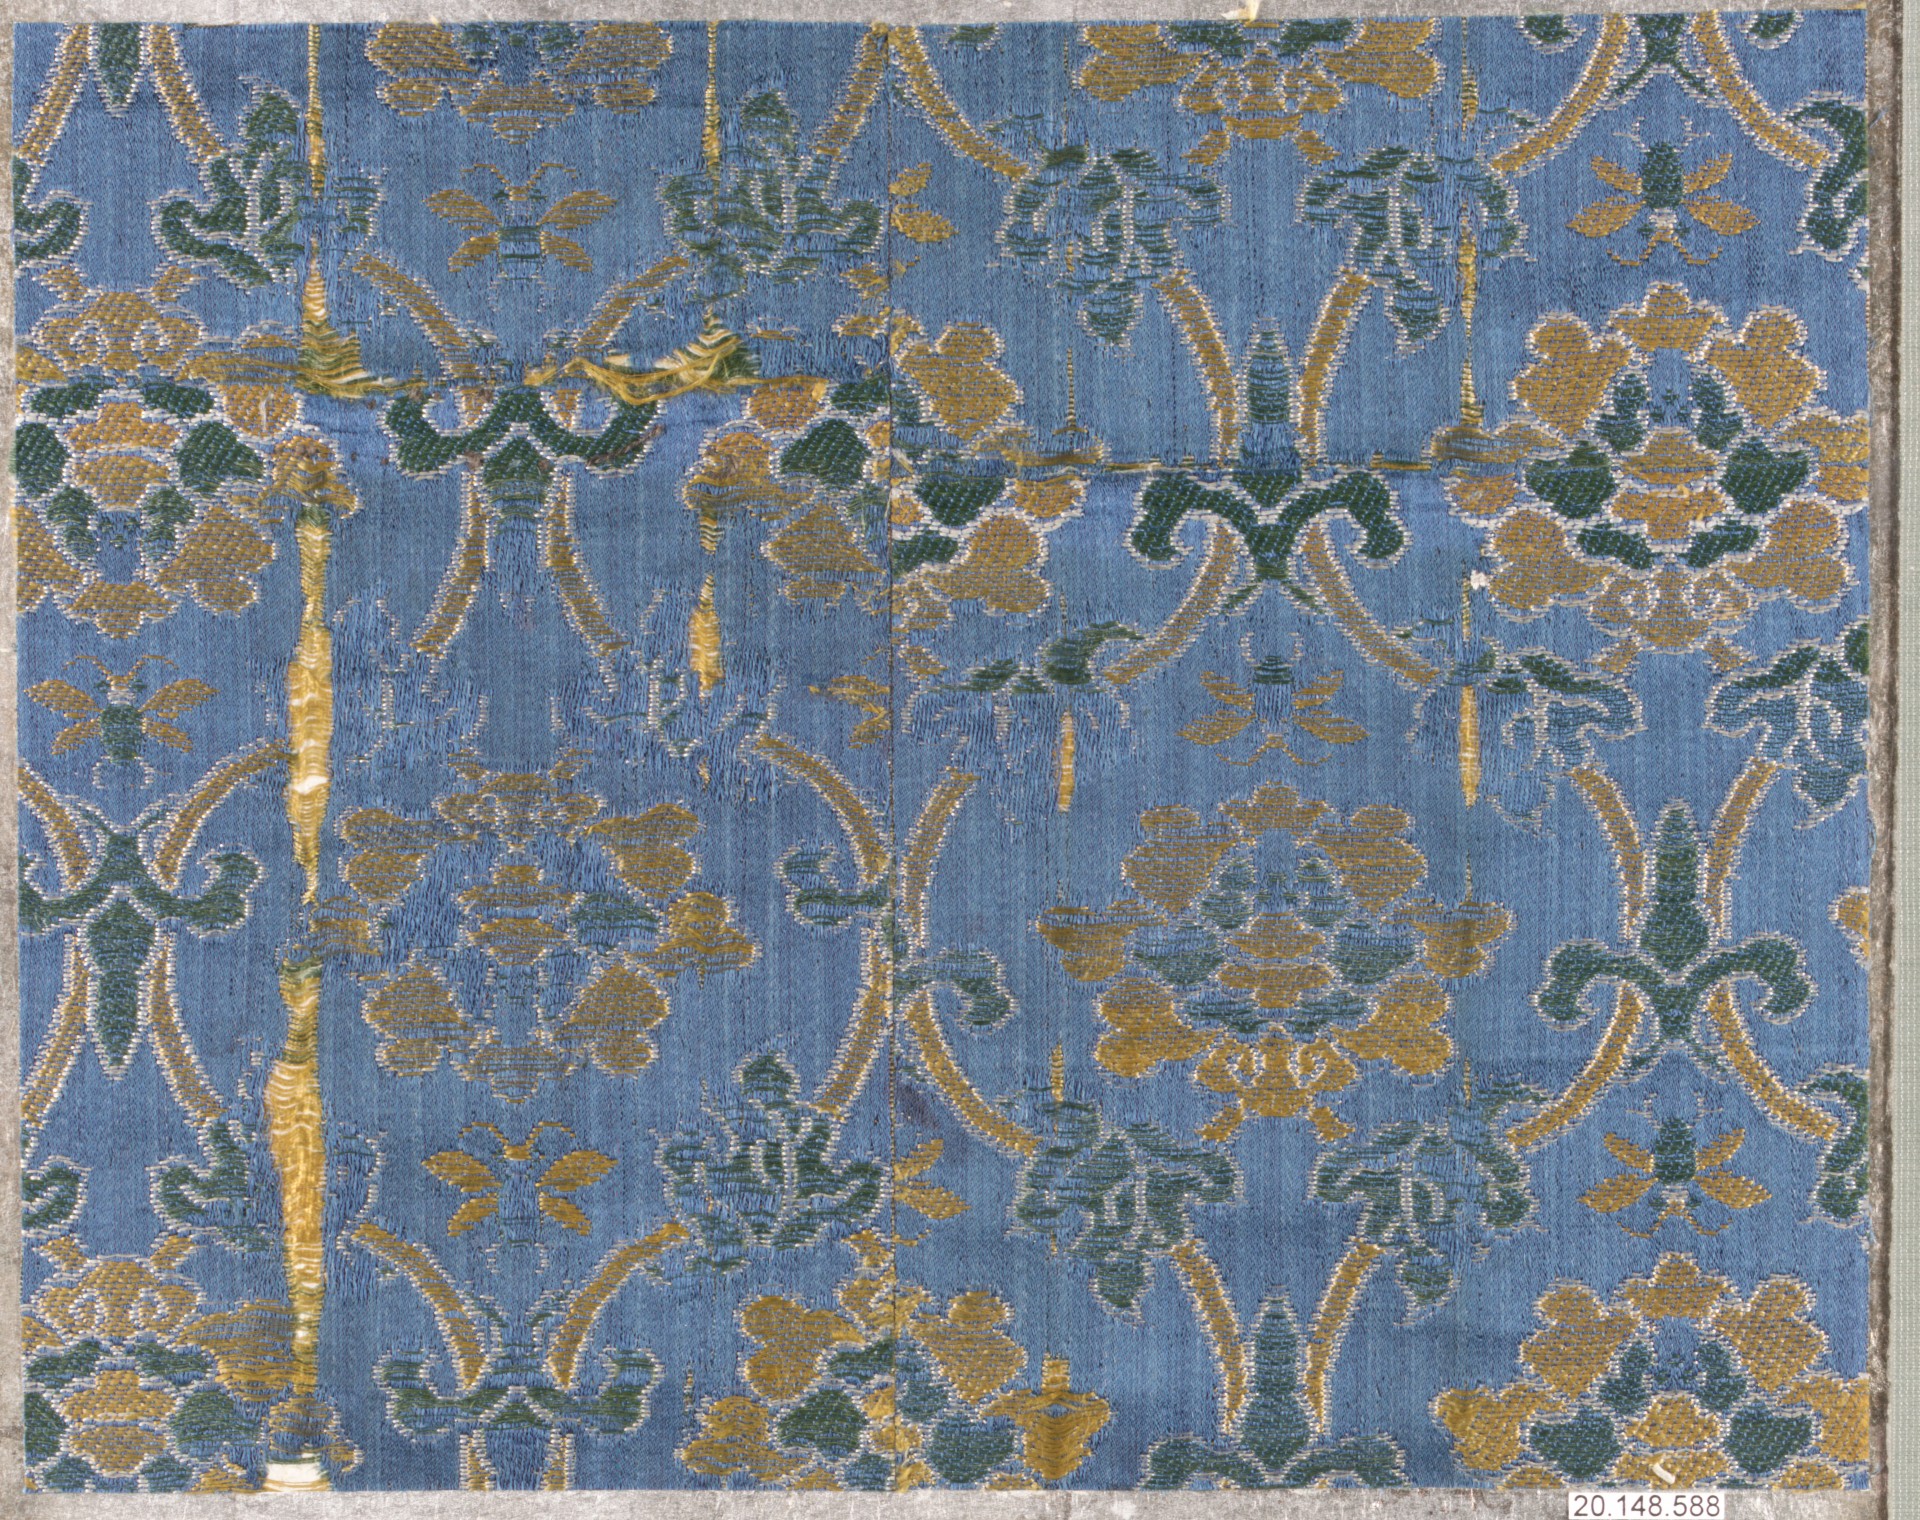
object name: piece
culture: japanese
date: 1601-1700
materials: silk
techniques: compound weave